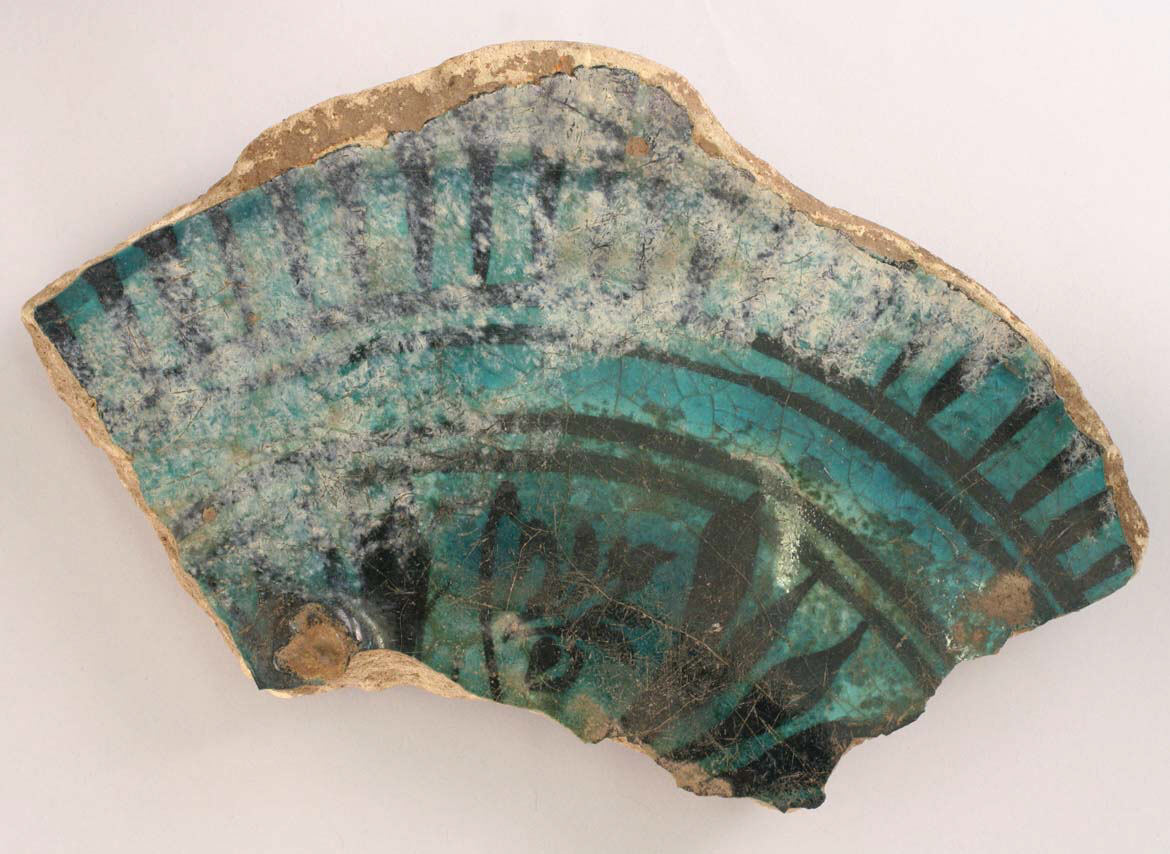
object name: fragment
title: Ceramic Fragment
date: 1301-1500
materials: glaze, stonepaste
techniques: painting, underglaze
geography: syria